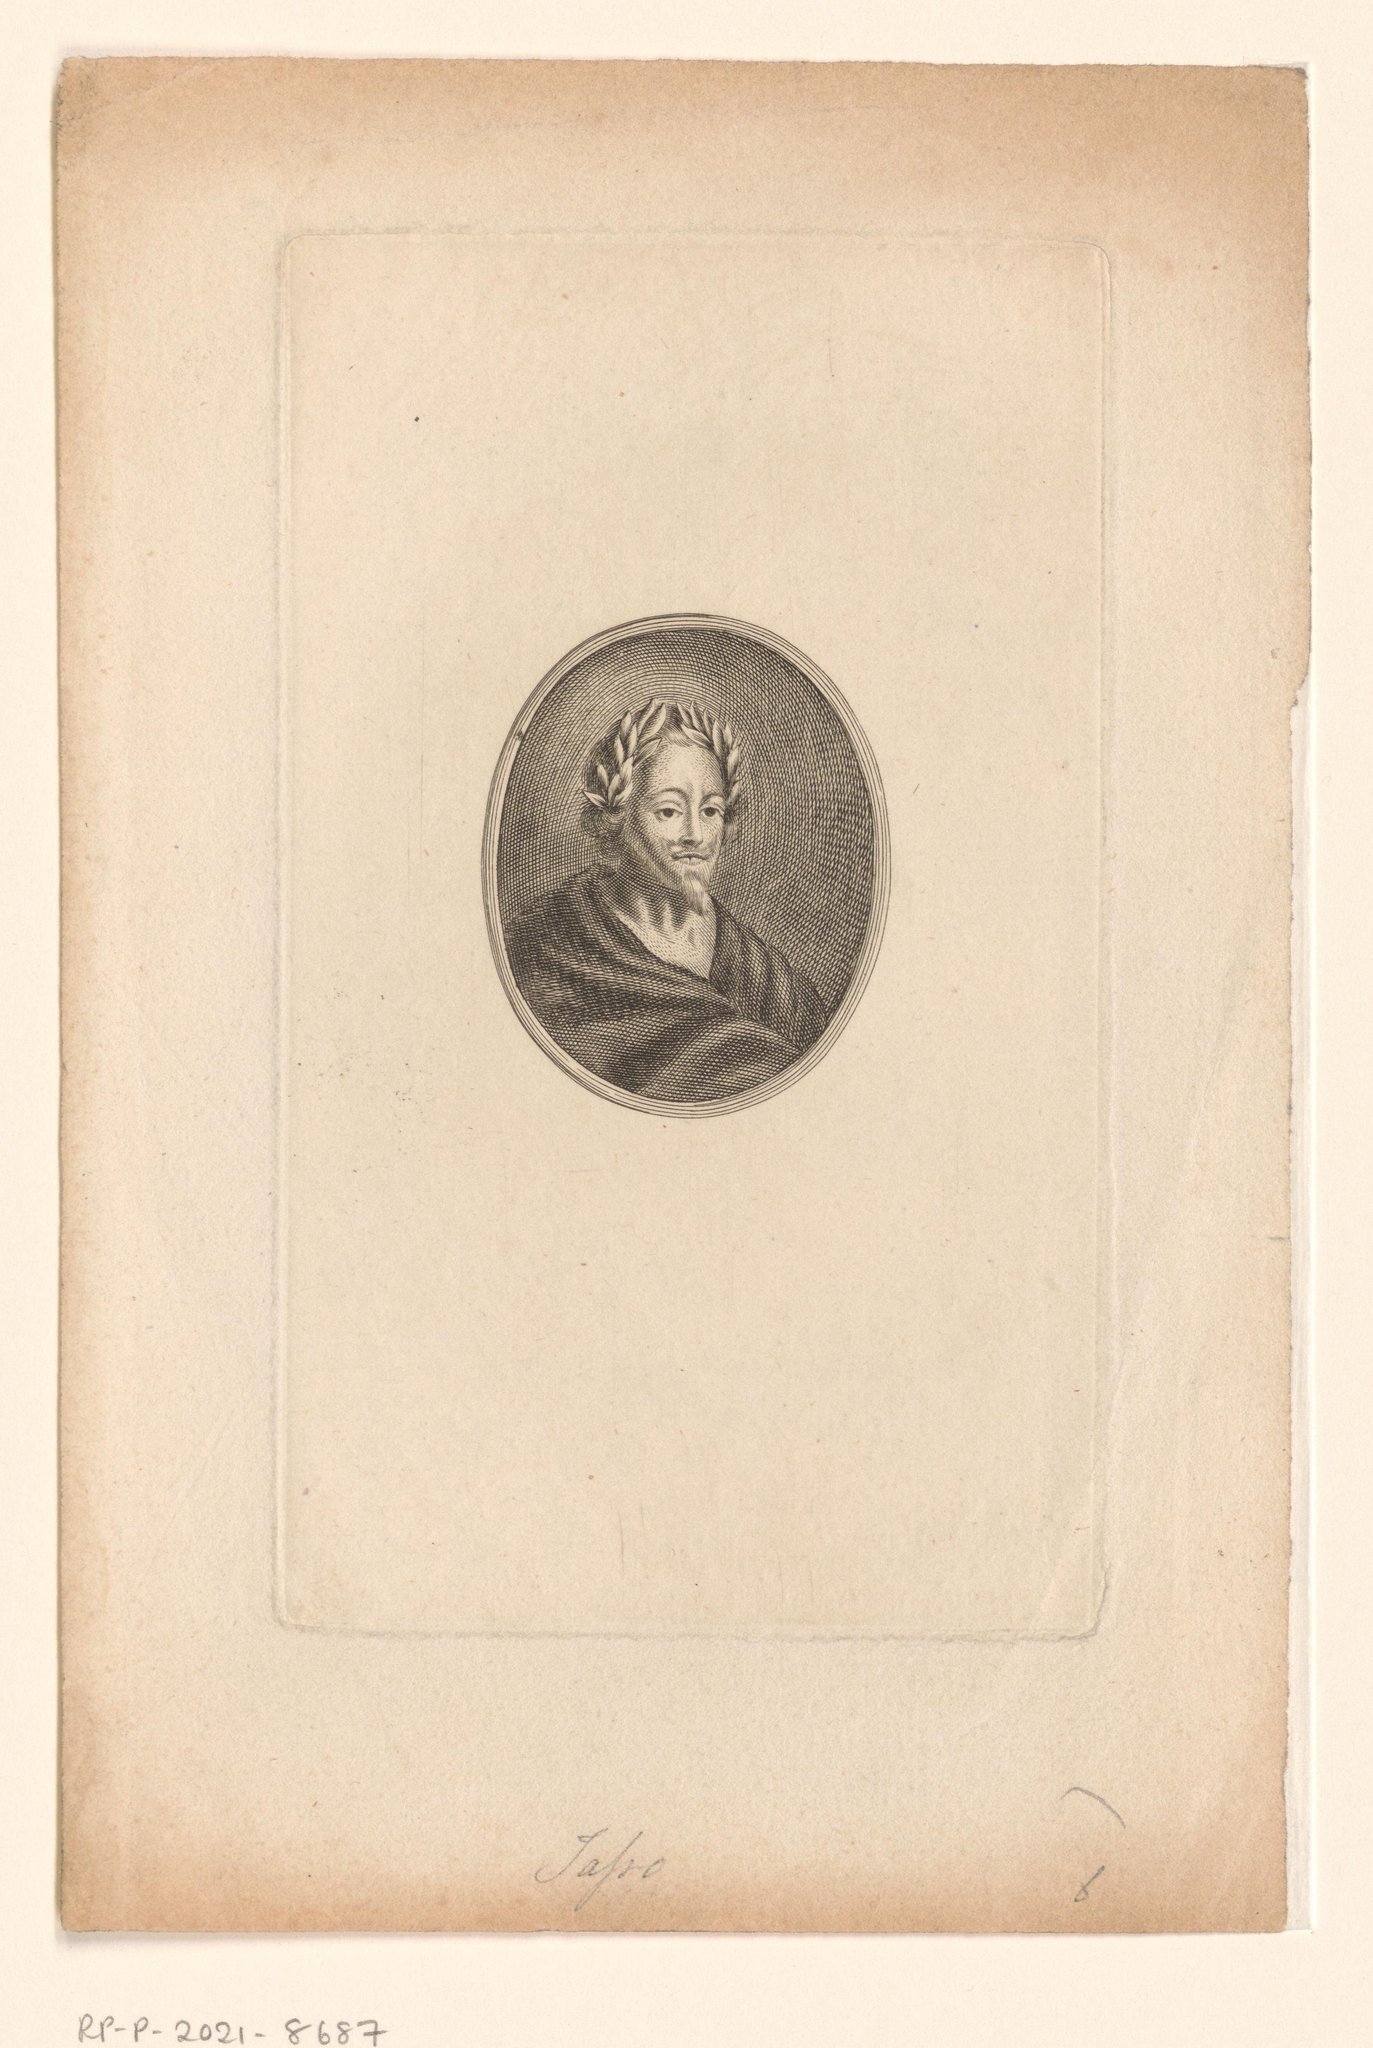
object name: print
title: Portret van Torquato Tasso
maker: Anonymous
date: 1700-1799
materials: paper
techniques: engraving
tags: rome, torquato tasso, historical persons, writer, poet, author